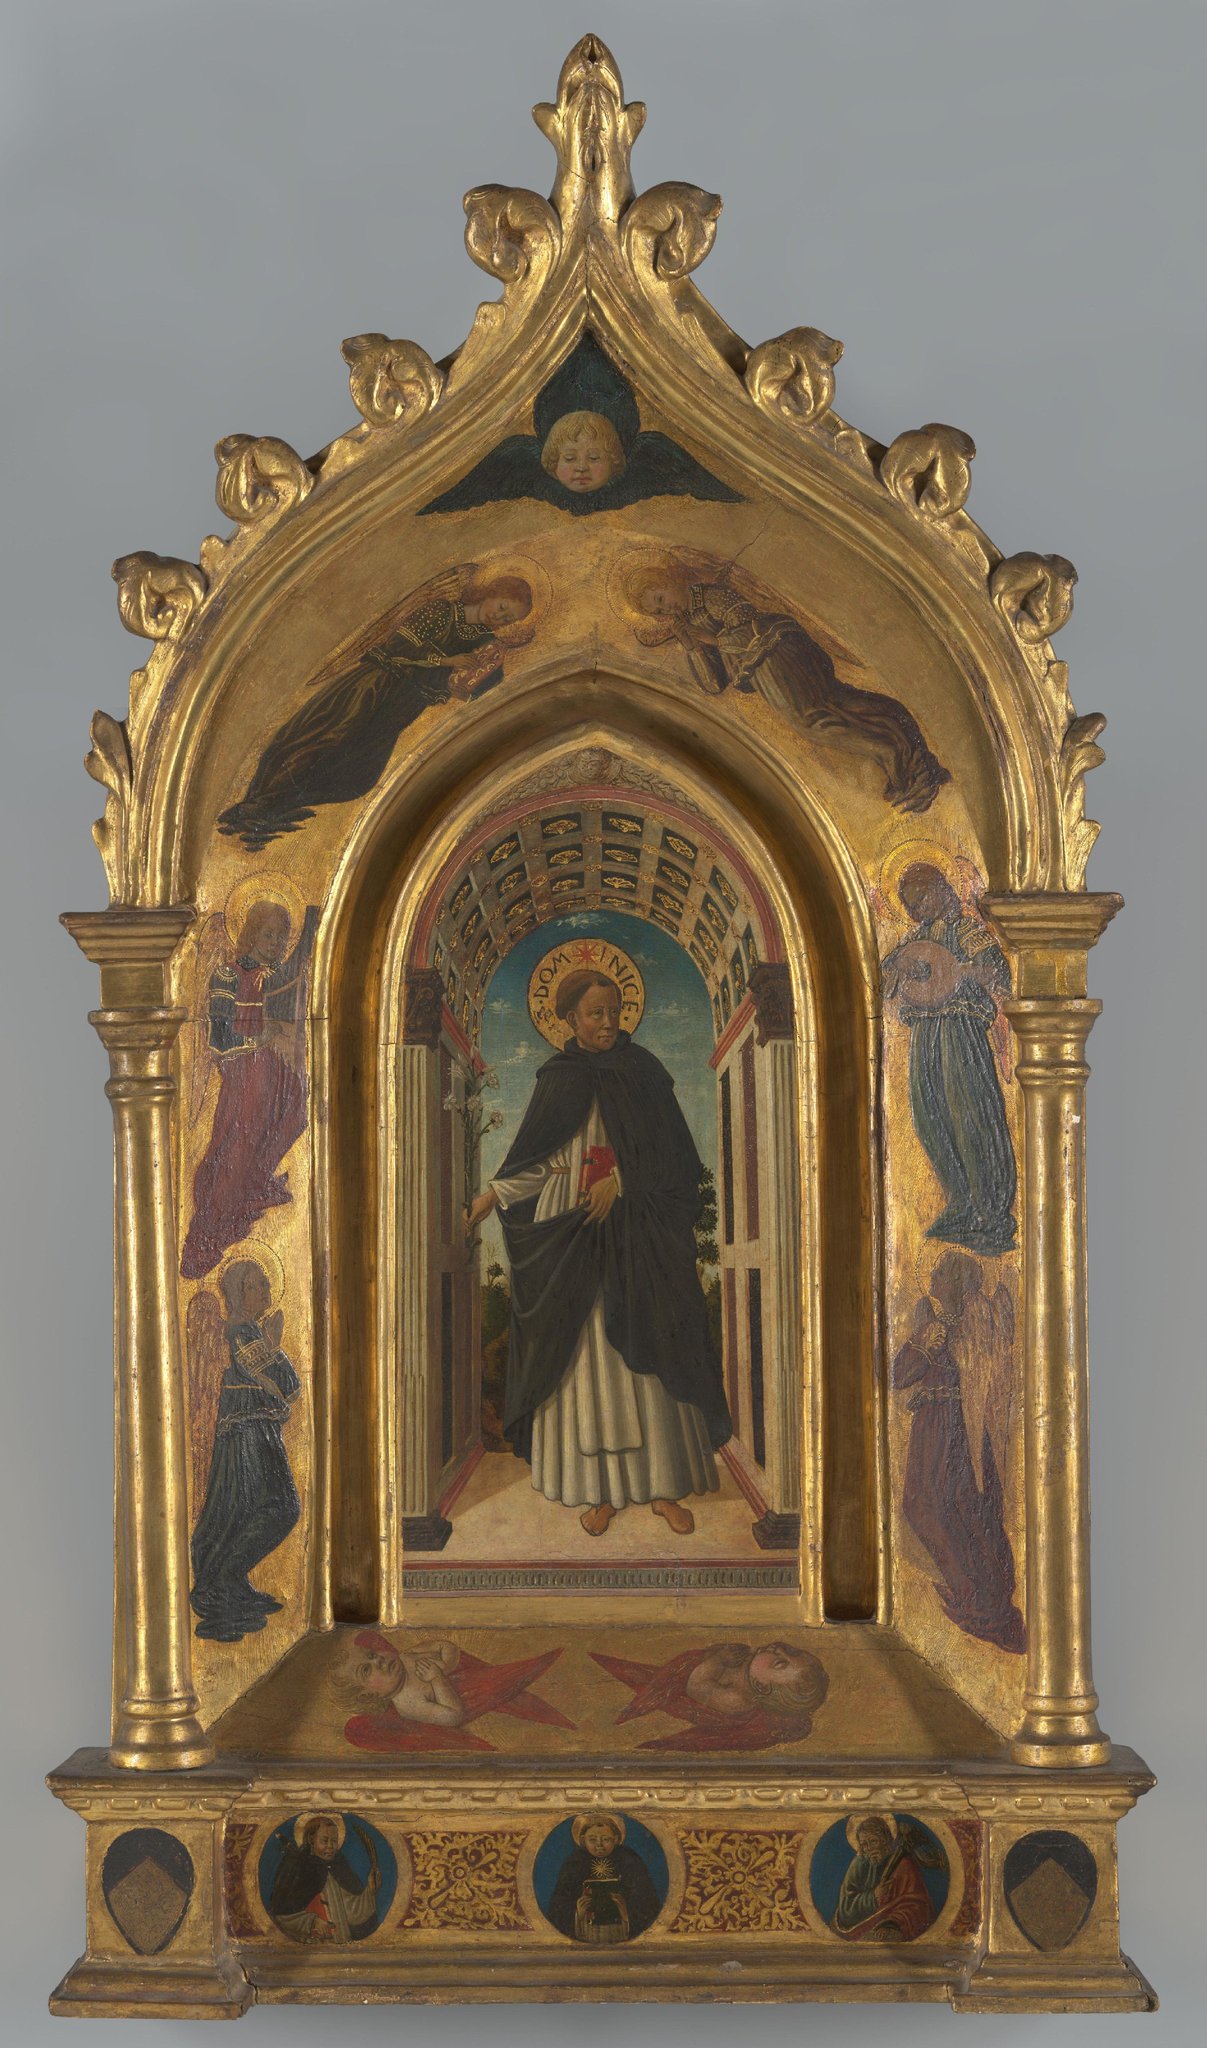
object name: painting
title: Saint Dominic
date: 1450-1499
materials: oil, panel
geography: florence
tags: dominic(us) guzman of calerueja, founder of the order of preachers (or dominican (black) friars; possible attributes: book, dog with flaming torch, lily, loaf of bread, rosary, star, the dominican theologian, 'angelic doctor' thomas of aquino; possible attributes: book, (chain with) sun, dove, girdle of chastity, lily, model of church, monstrance (or chalice), mitre (under feet), star (on breast)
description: De heilige Dominicus, staande ten voeten uit in een poort met een lelietak in de rechterhand en een boek in de linkerhand. Op de omlijsting engelen en serafijnen, op de predella medaillons met de heiligen Petrus Martyr, Thomas van Aquino en Mattheüs. Met geïntegreerde lijst.